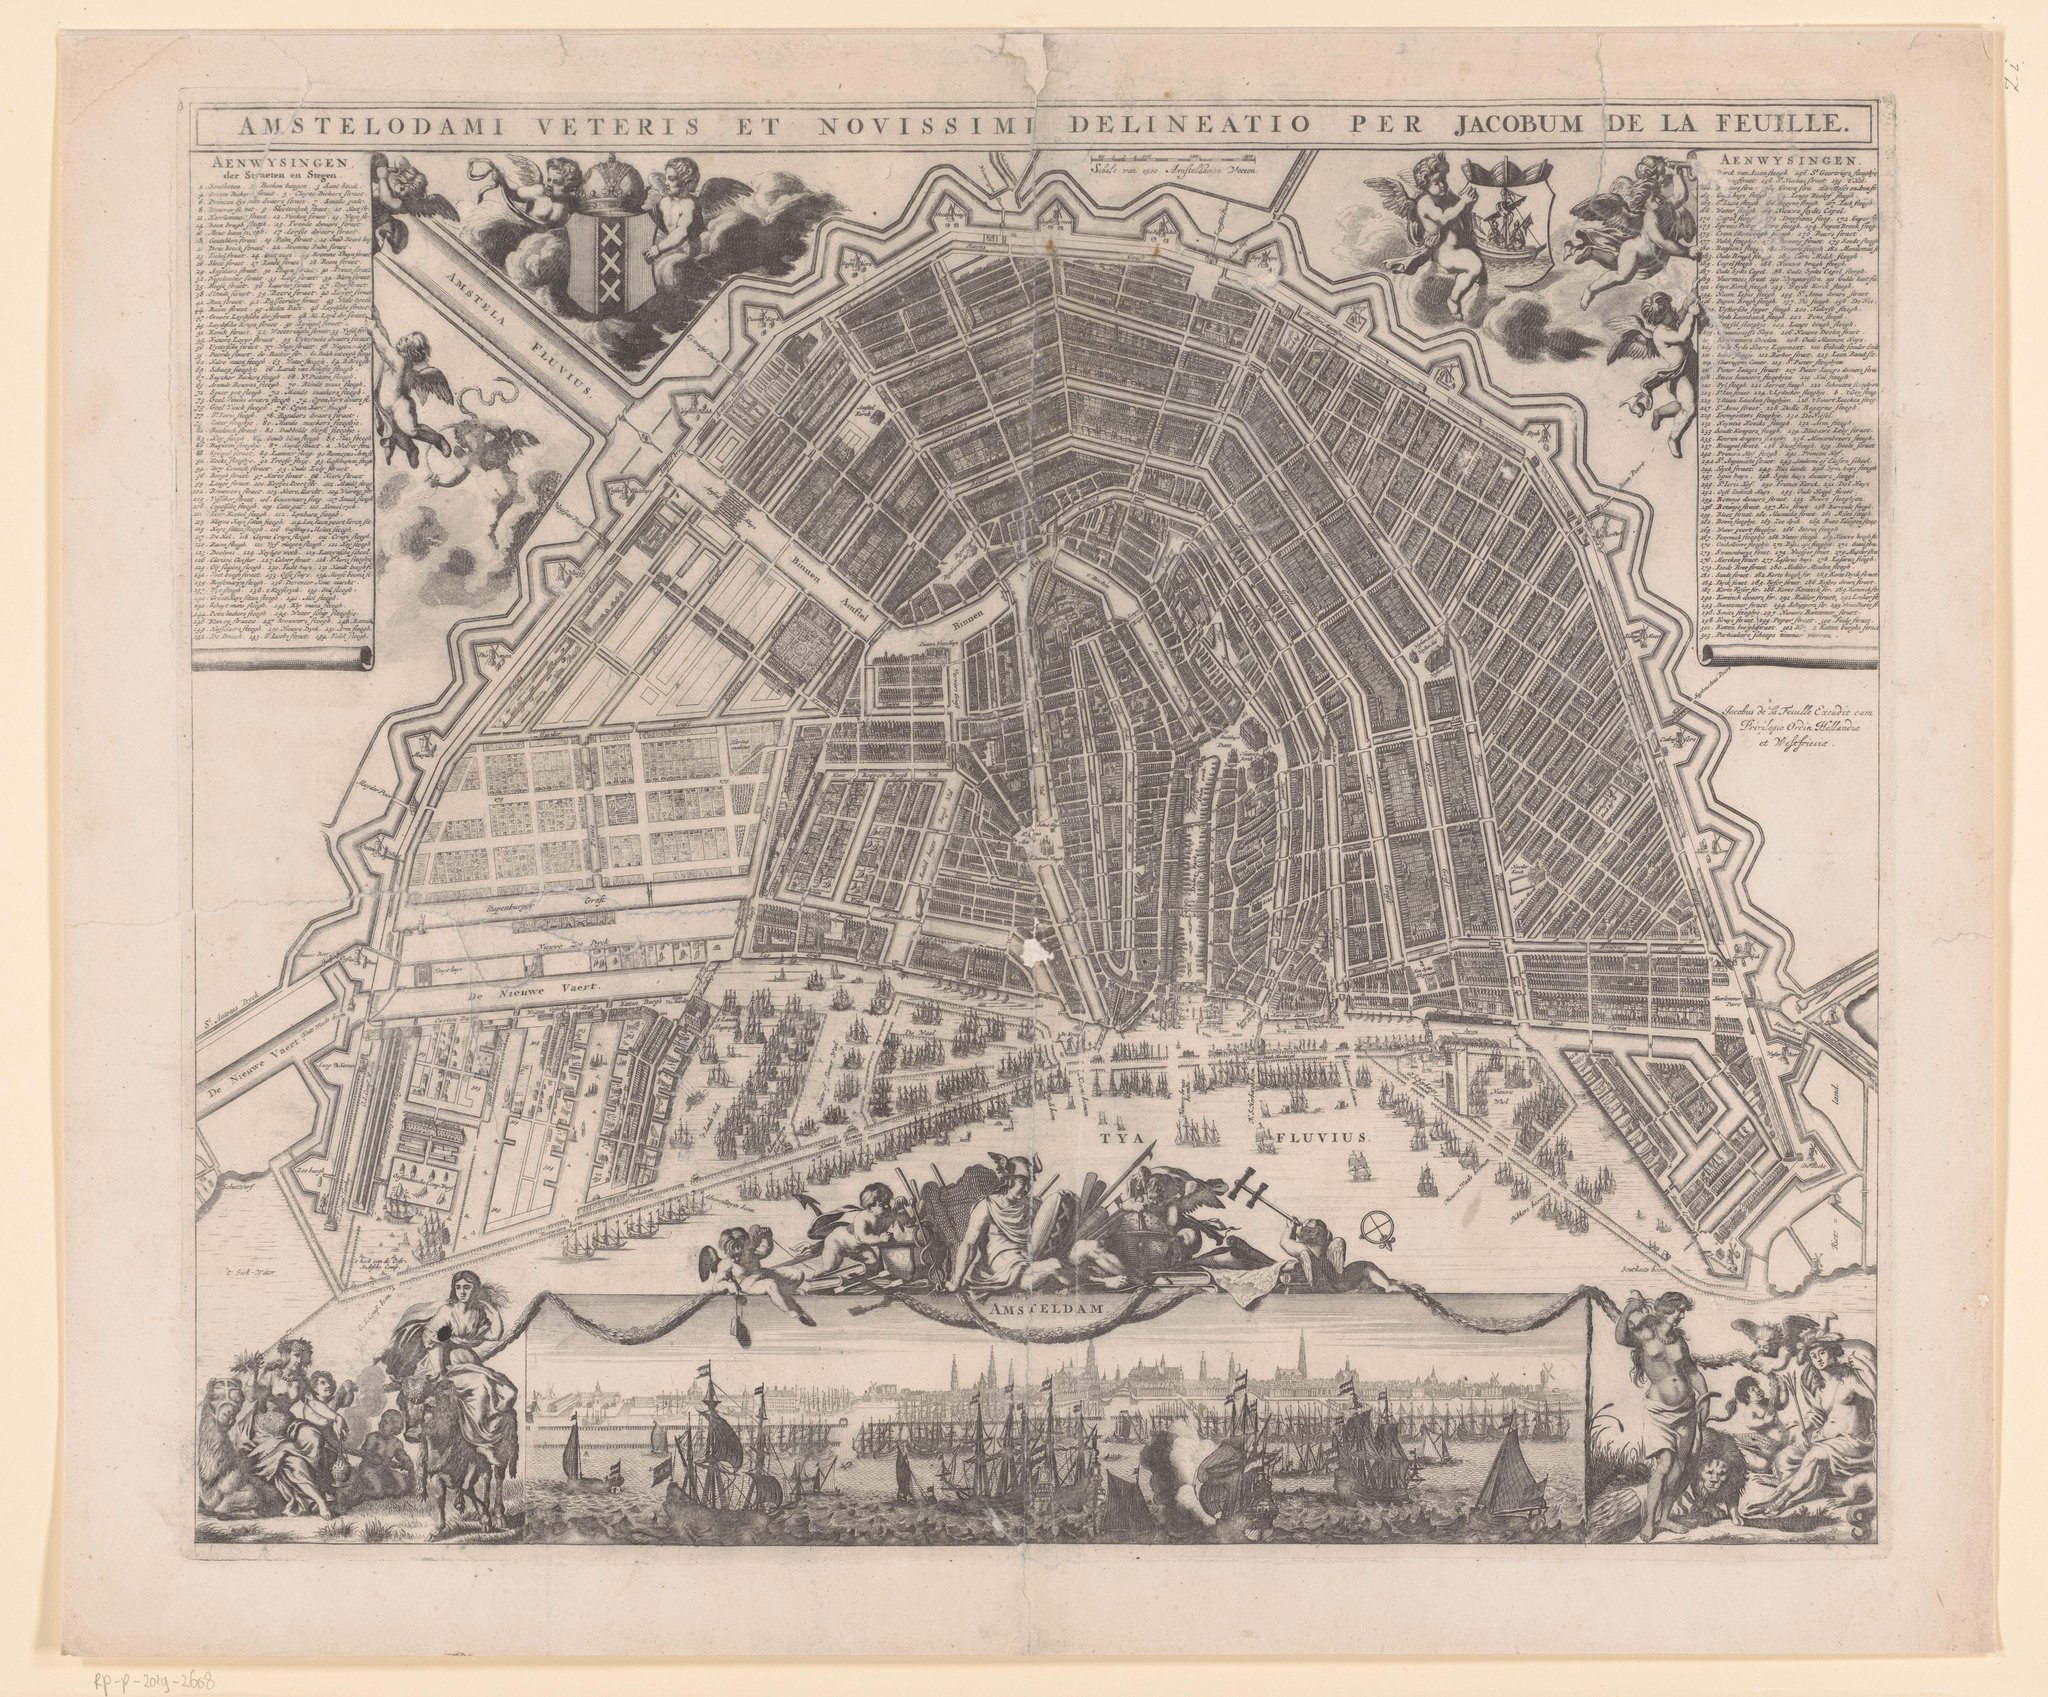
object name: area plan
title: Plattegrond van Amsterdam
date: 1693-1719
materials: paper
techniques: etching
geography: amsterdam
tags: (story of) mercury (hermes), ships (in general) - cc - more than one ship, maps of cities, position-finding at sea; nautical instruments, prospect of city, town panorama, silhouette of city, amsterdam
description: Links een legenda 1-152, rechts een legenda 155-303. Onderaan de prent een gezicht op de stad vanaf het IJ.